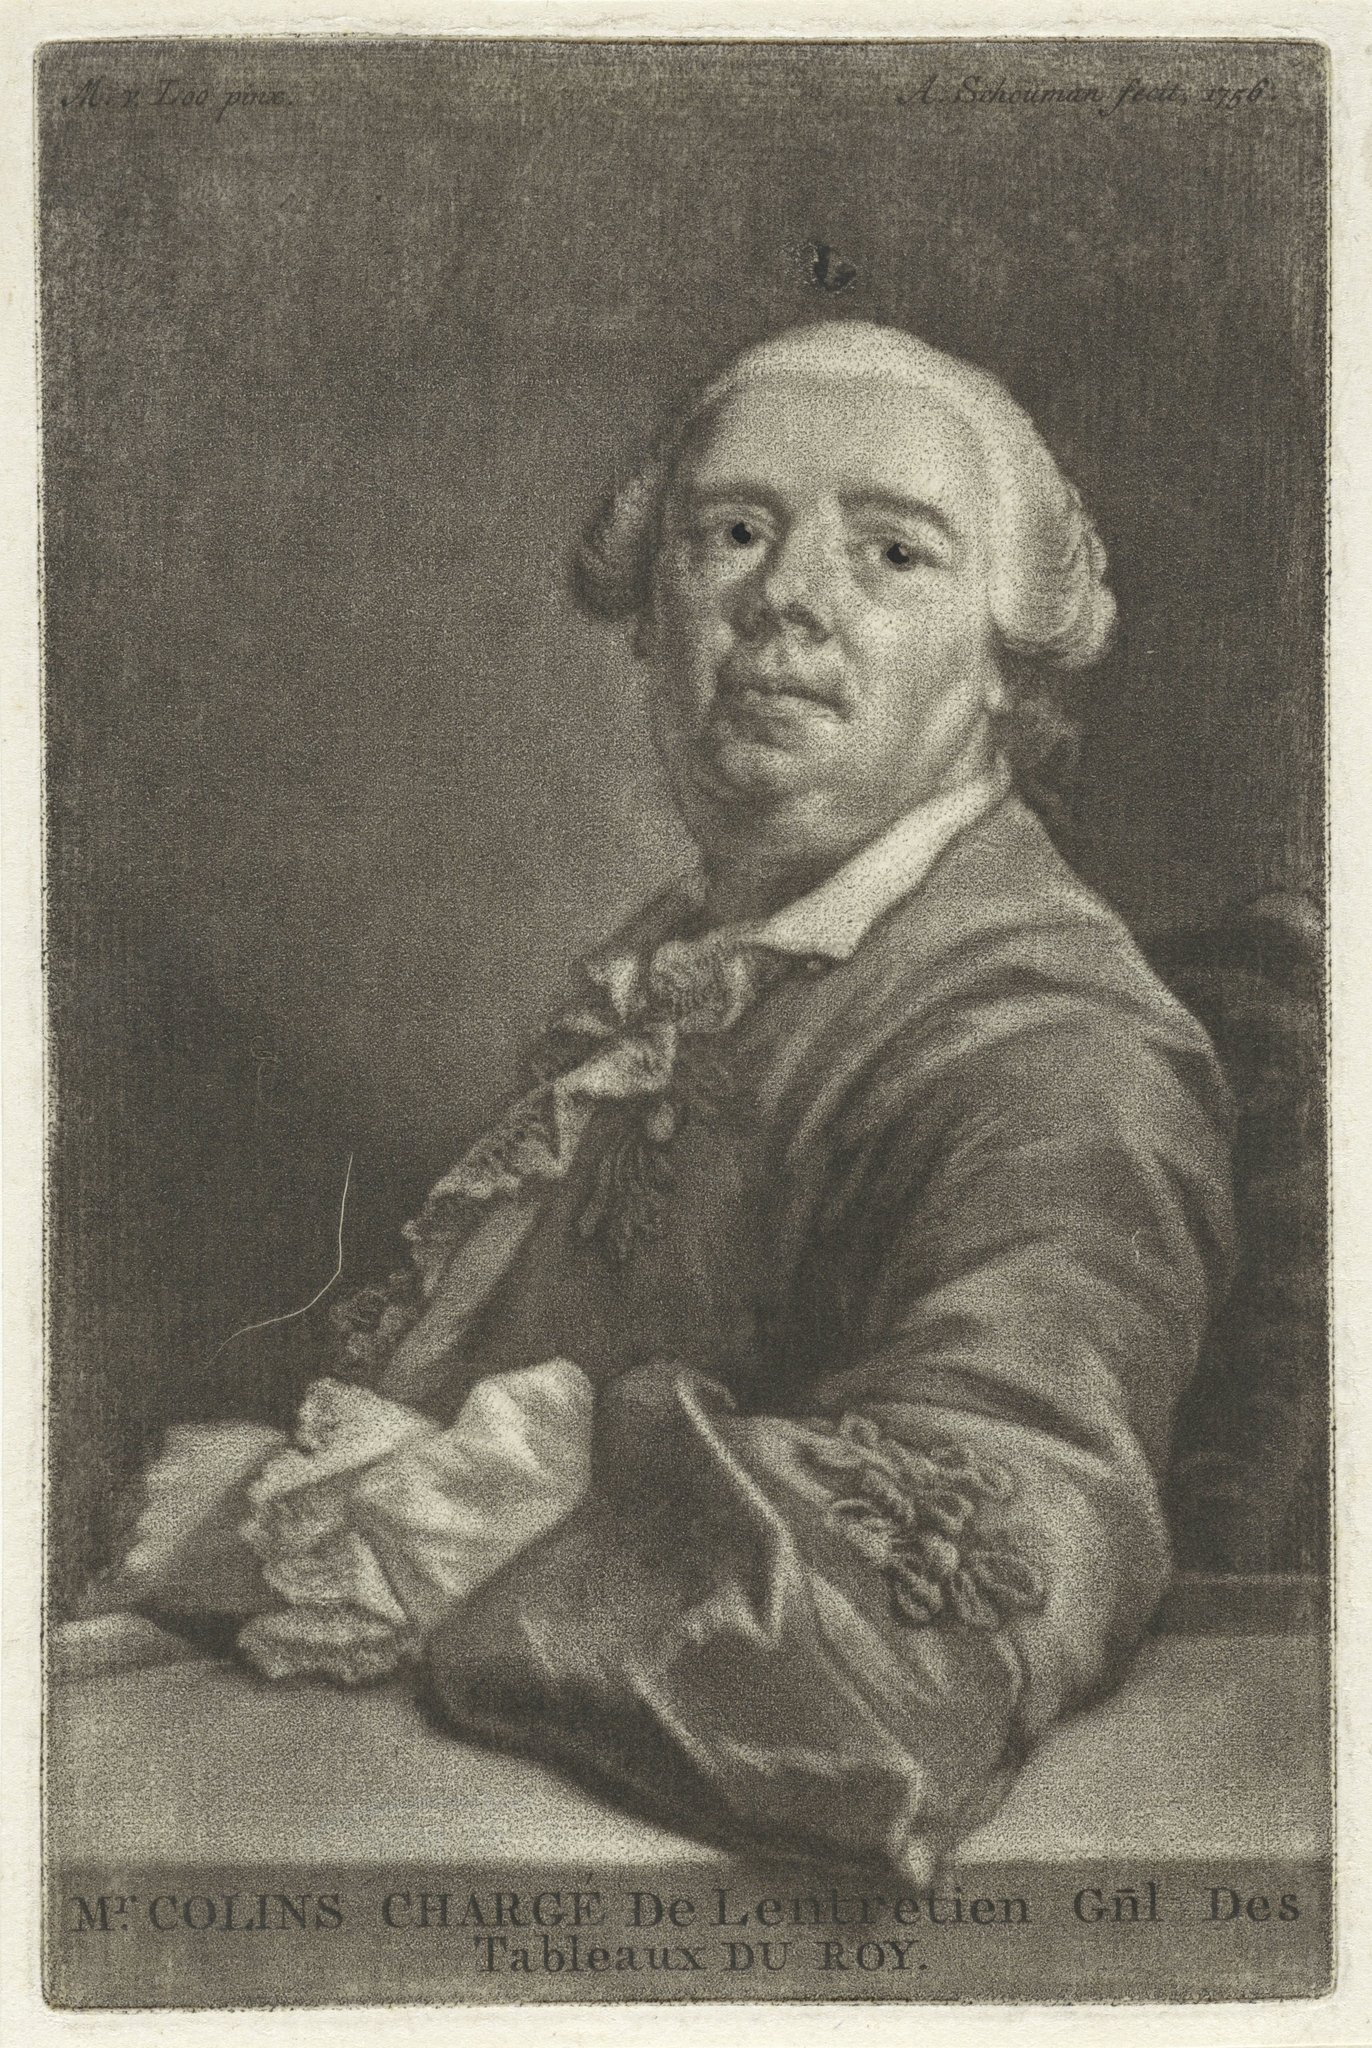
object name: print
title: Portret van François-Louis Colins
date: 1756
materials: paper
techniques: engraving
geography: the hague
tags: conservator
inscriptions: collector's mark: Lugt 2228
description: De Franse kunsthandelaar François-Louis Colins. Hij was vanaf 1743 conservator en restaurator van het Louvre.